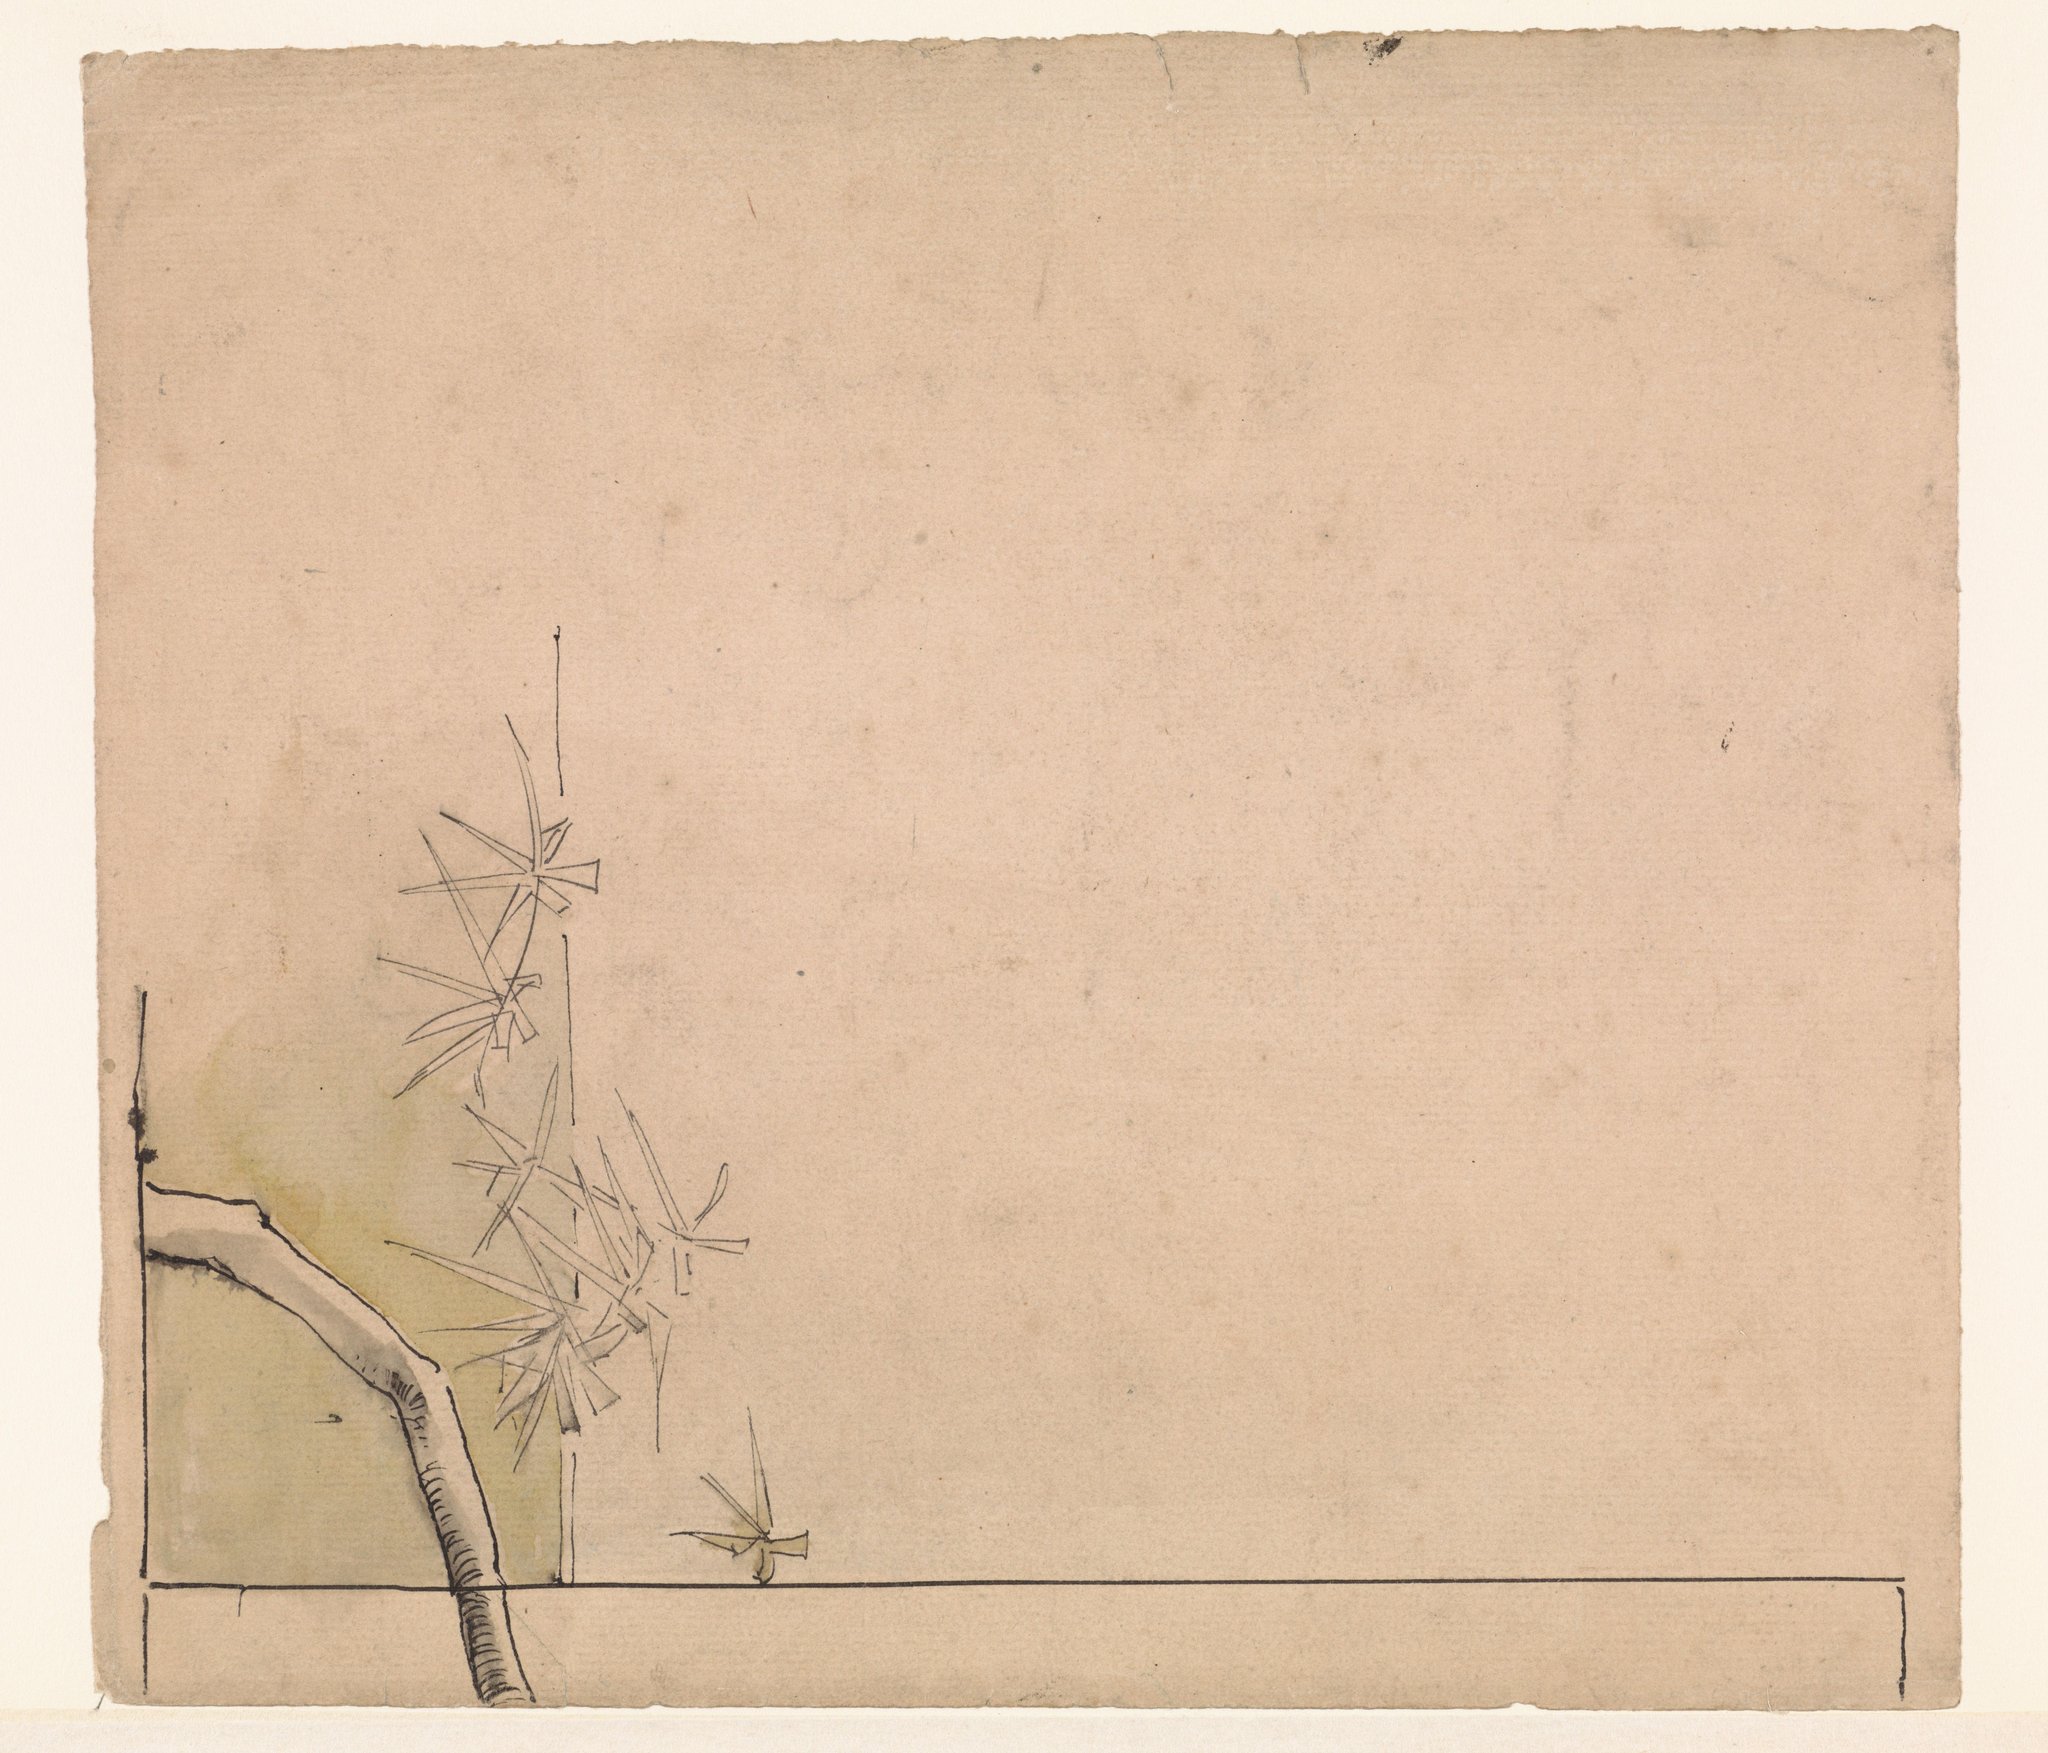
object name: drawing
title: Ontwerp voor de achterkant van een omslag van een album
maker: edzard koning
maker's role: draughtsman, print maker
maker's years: 1869-1954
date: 1879-1954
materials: ink, paper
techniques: brush, pen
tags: (versjes) specific works of literature (with author, title), book-cover, binding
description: Ontwerp voor de achterkant van een omslag van een album 'Versjes'.